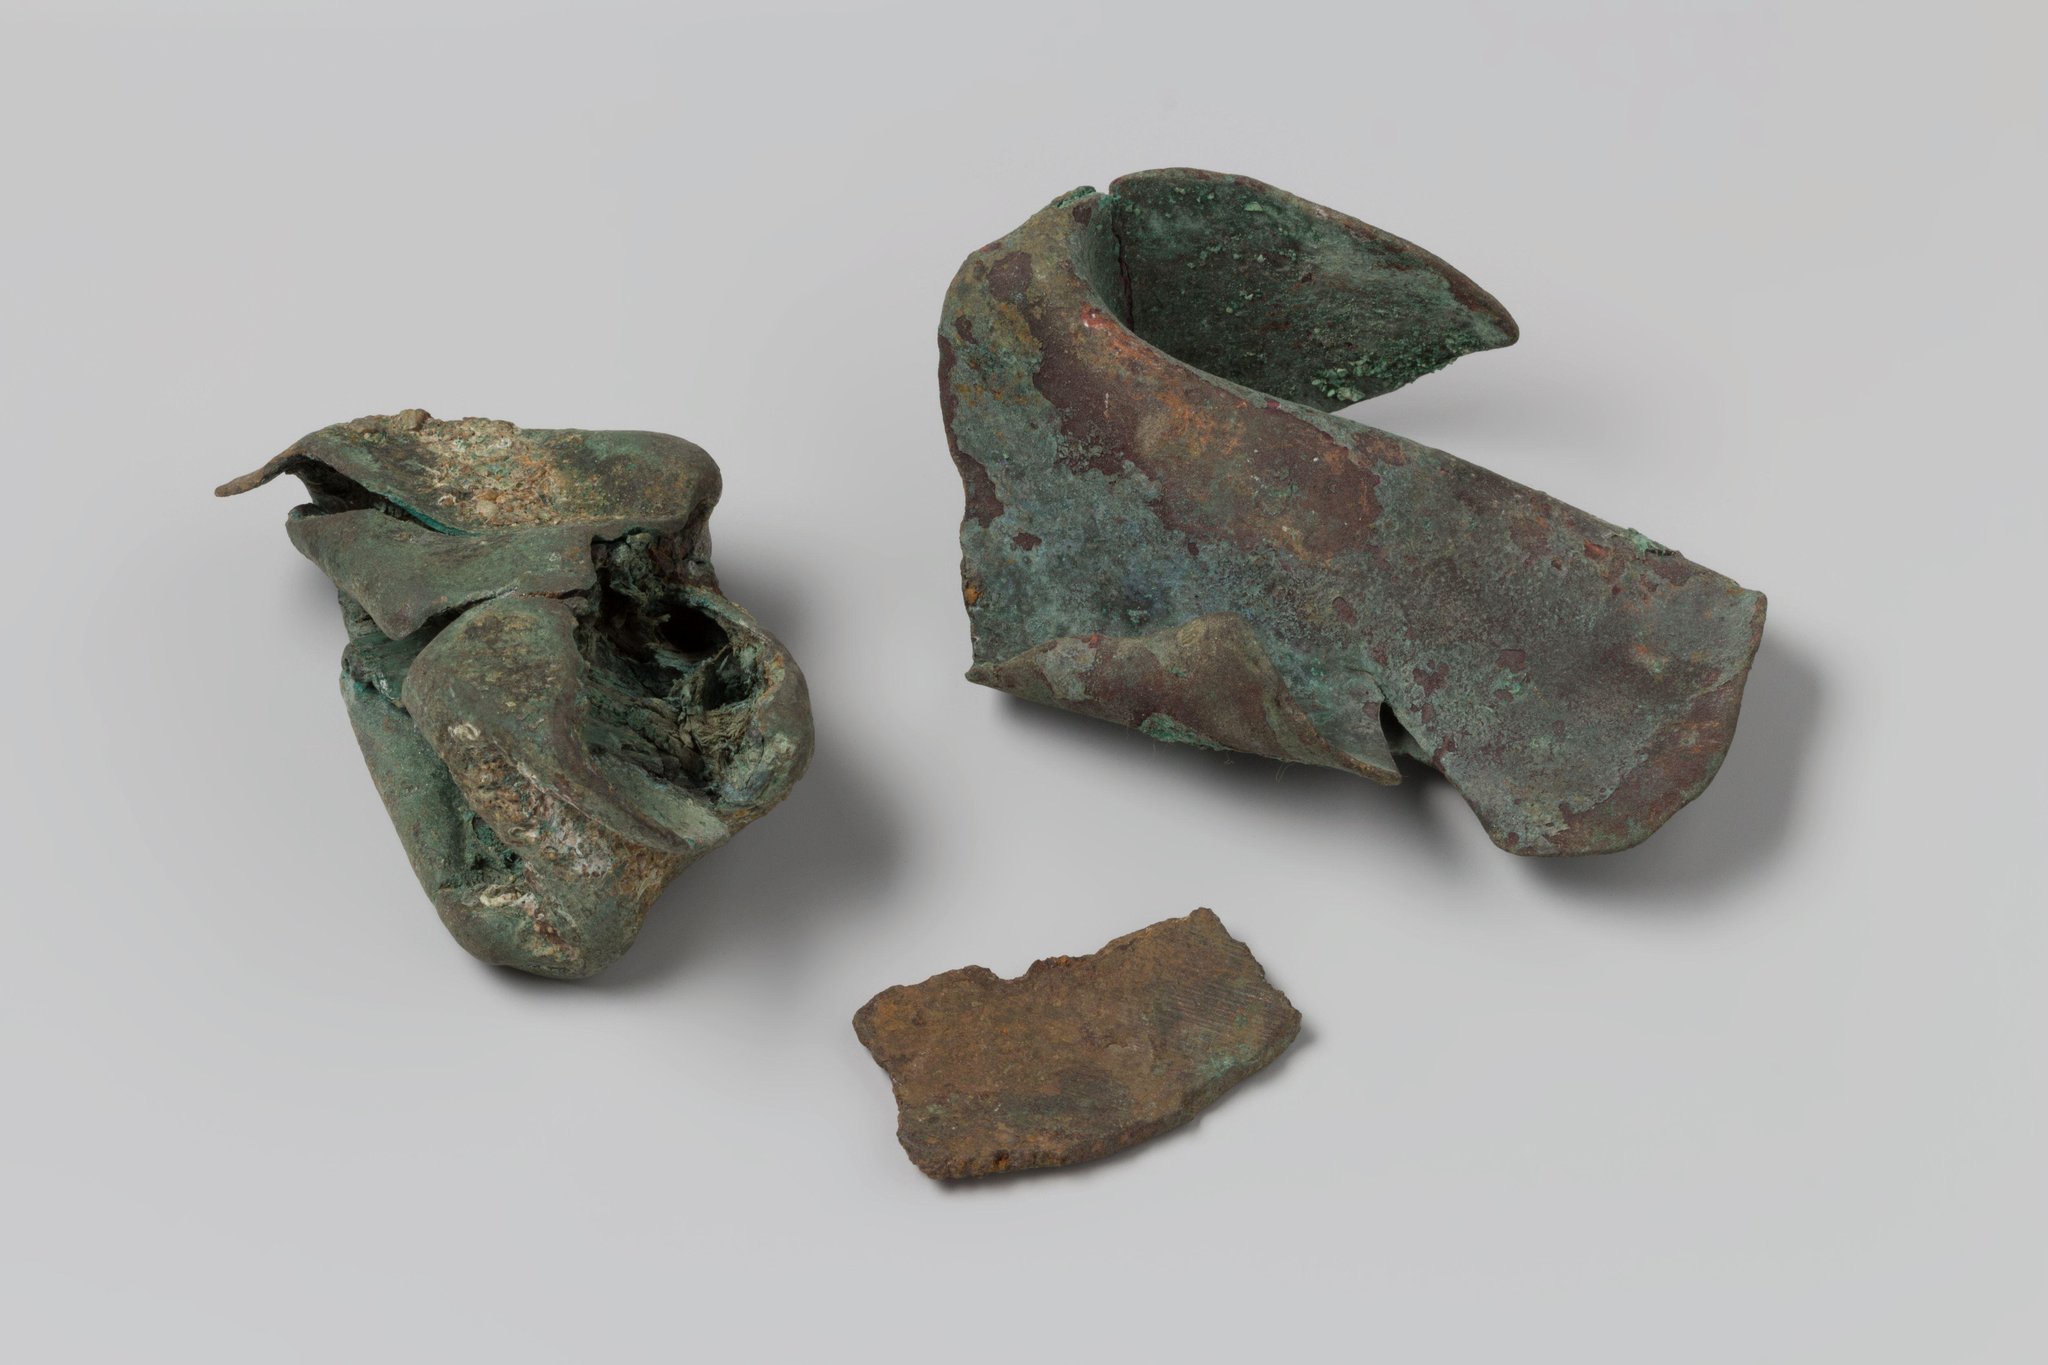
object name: scheepswrakvondst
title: Fragmenten van koper uit het wrak van de Oost-Indiëvaarder Hollandia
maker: Anonymous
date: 1700-1743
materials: copper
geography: netherlands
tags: verenigde oostindische compagnie, hollandia (schip), annet